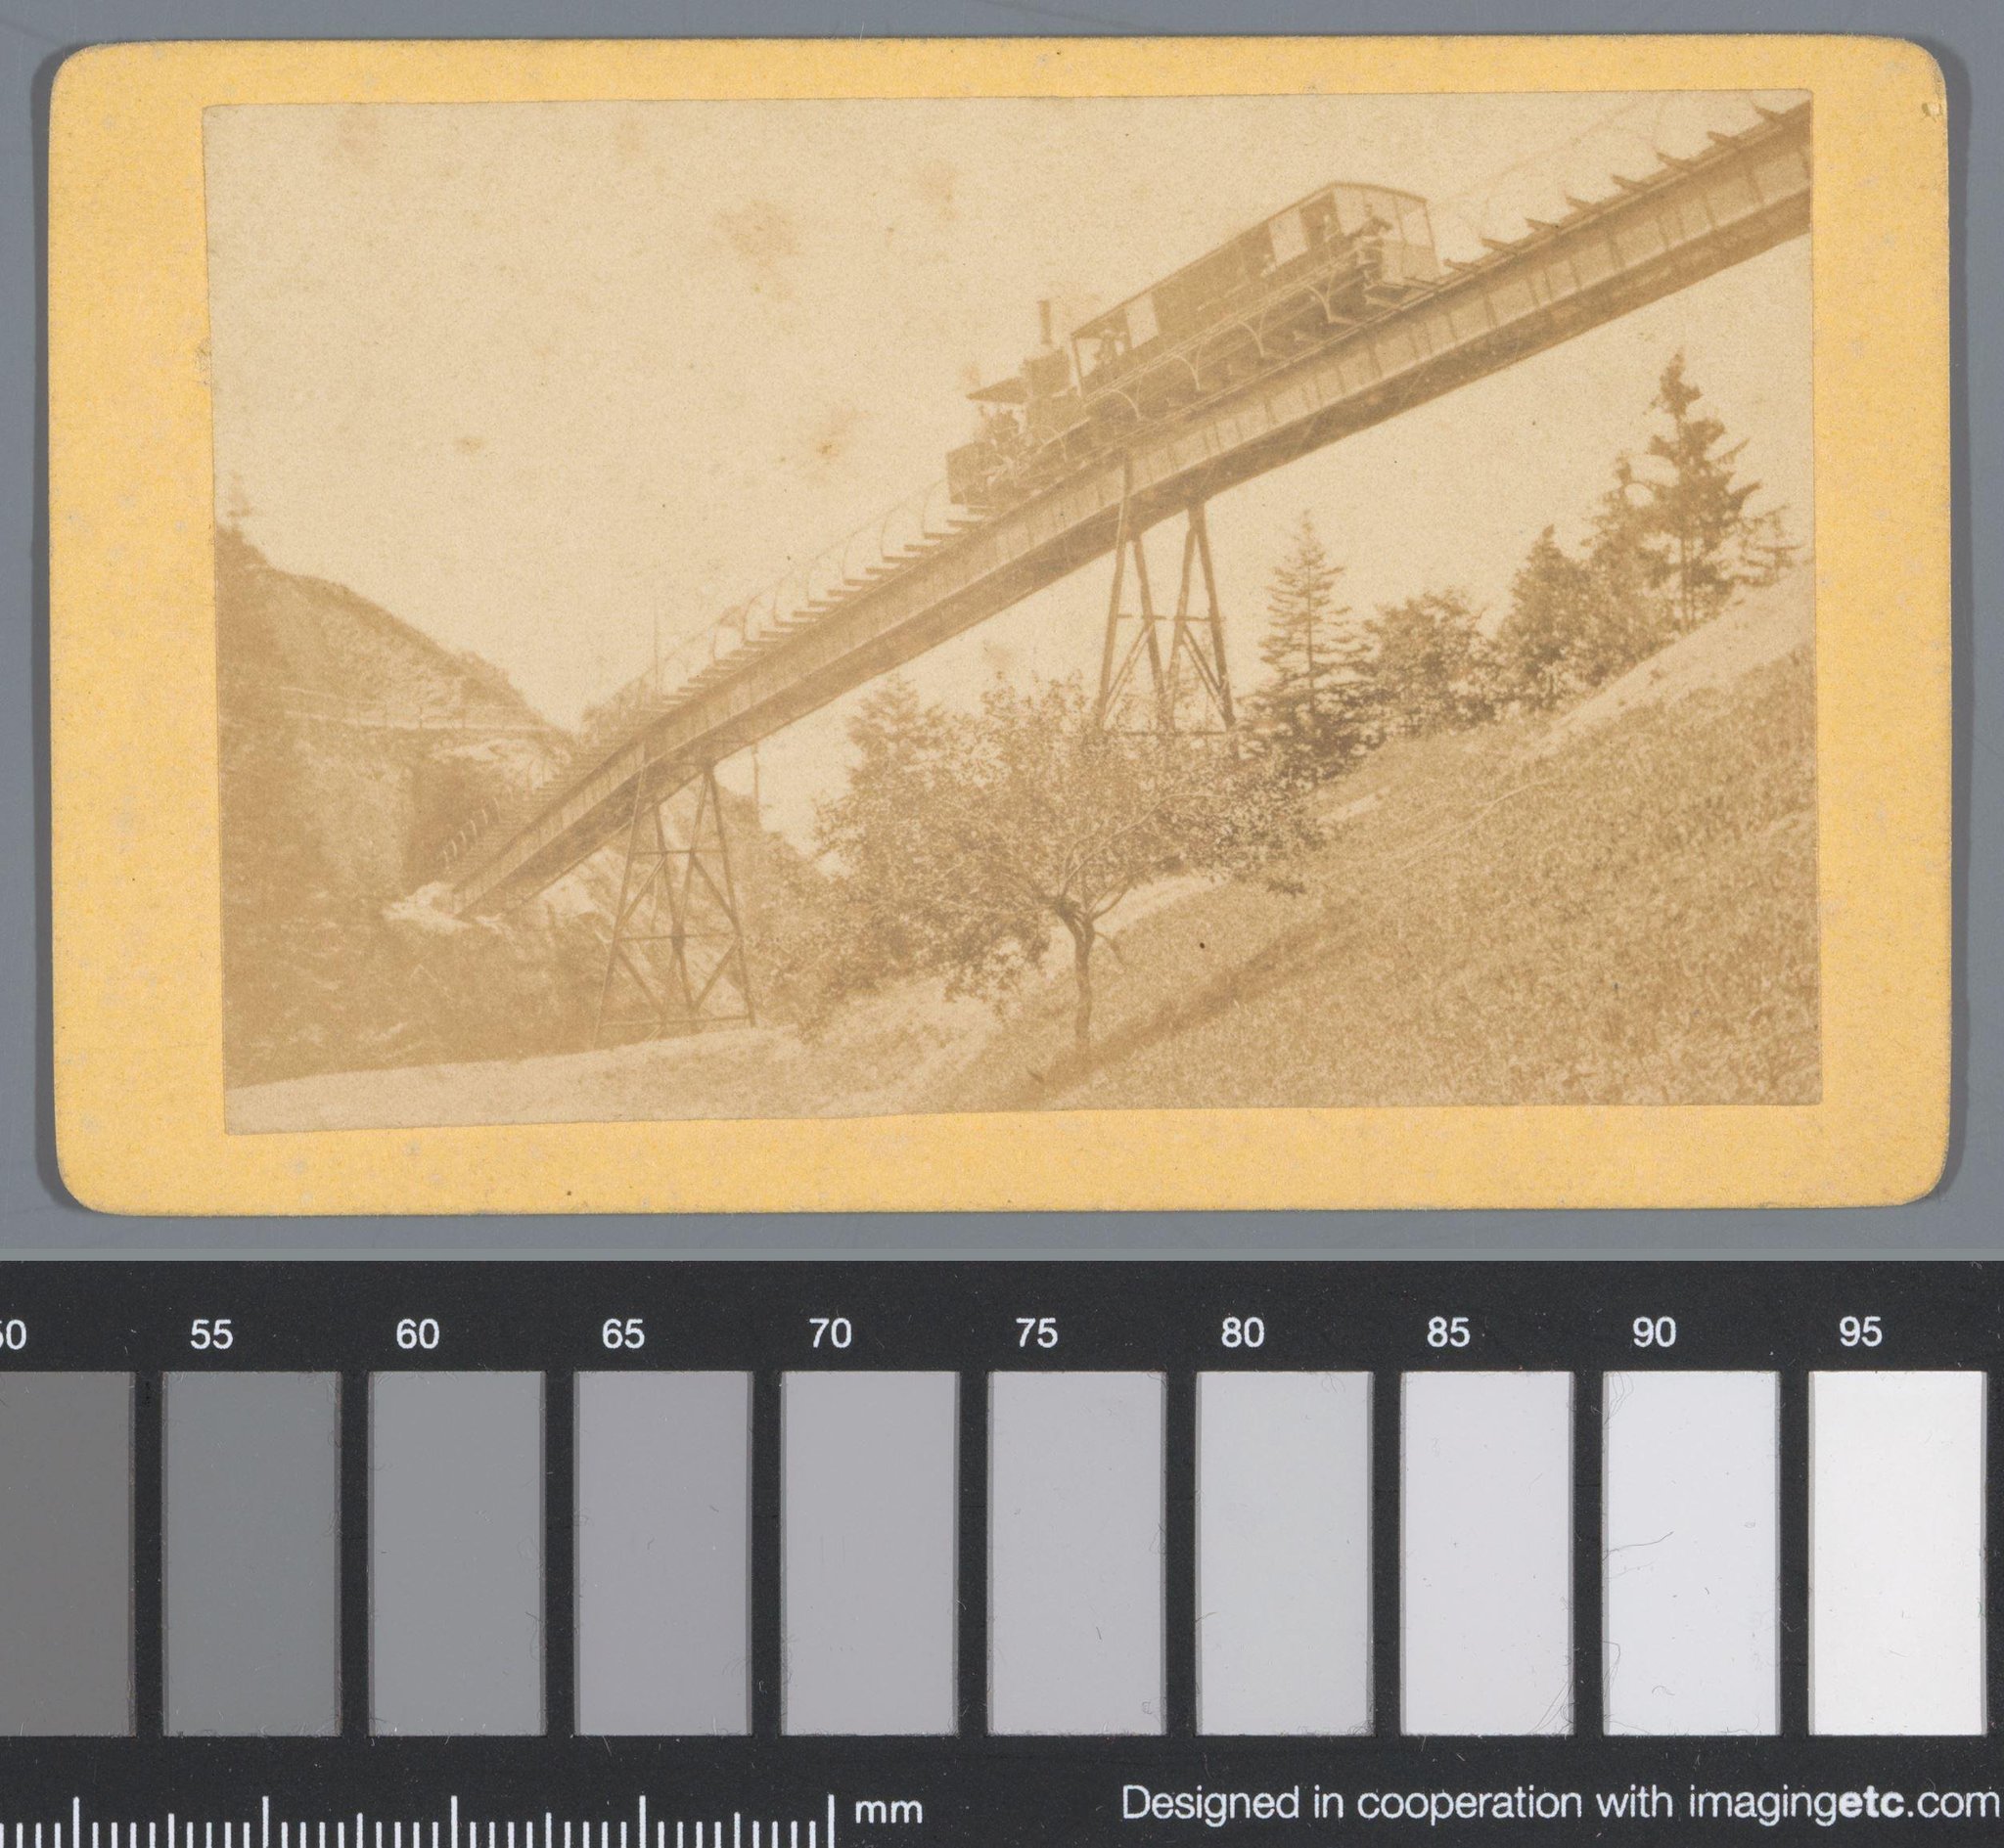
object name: photograph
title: Treinspoor op de Rigi, Zwitserland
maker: Anonymous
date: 1871-1885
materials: cardboard, paper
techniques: albumen print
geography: rigi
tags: railway, train